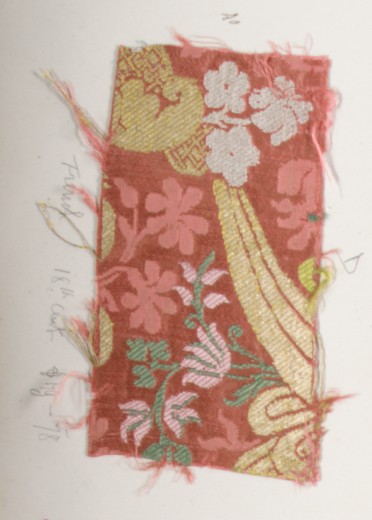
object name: fragment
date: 1701-1800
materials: metal thread, silk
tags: flowers,leaves